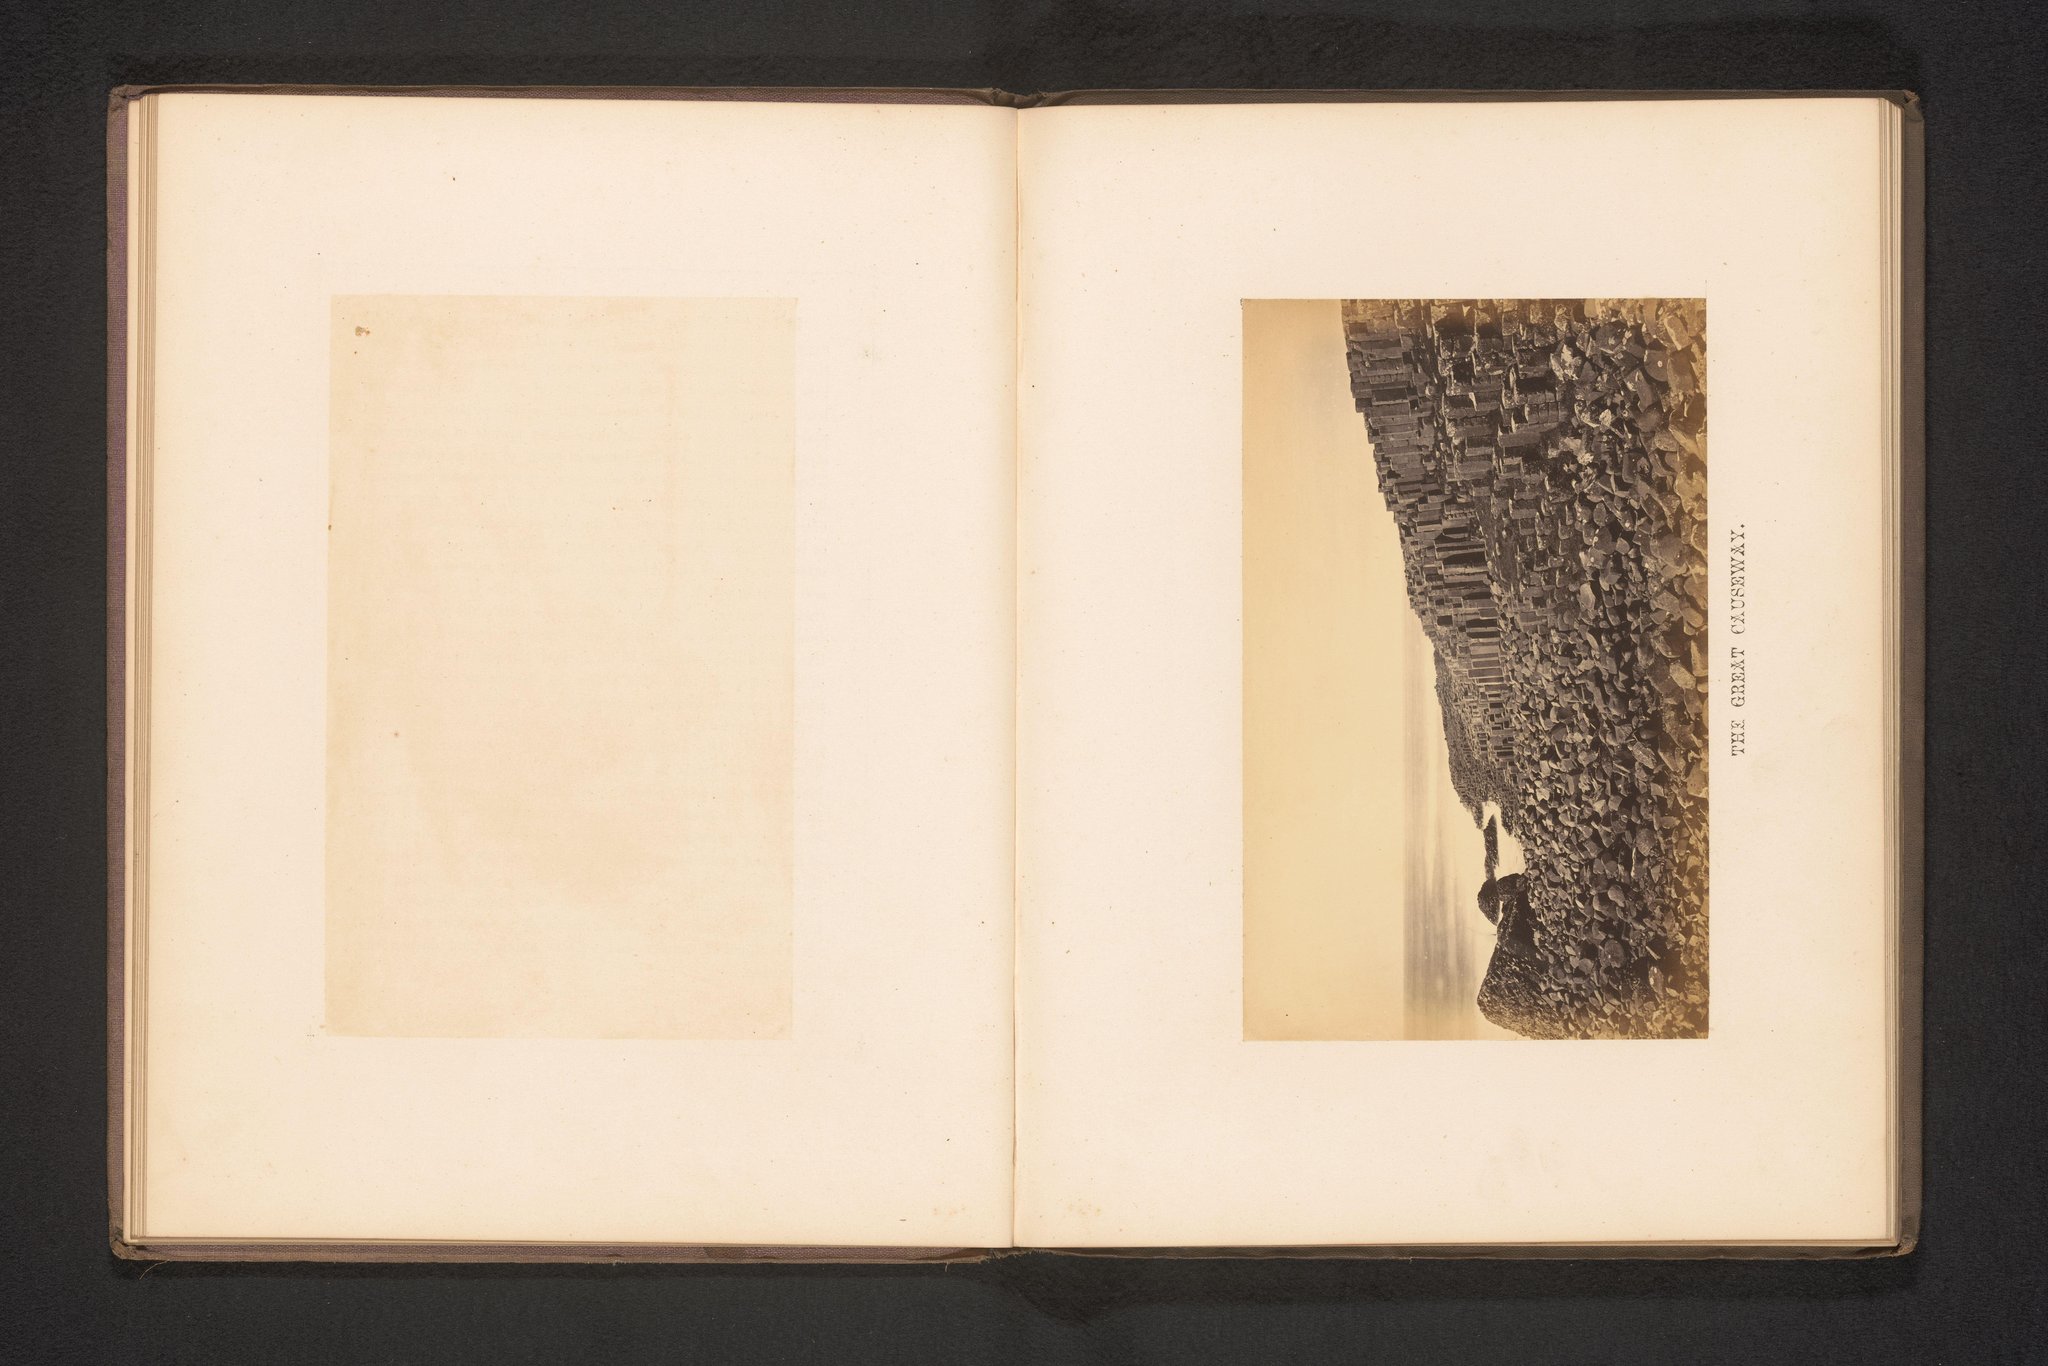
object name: page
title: Gezicht op Causeway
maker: john hudson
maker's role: fotograaf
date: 1862-1867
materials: photographic support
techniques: albumen print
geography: giant's causeway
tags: landscapes with waters, waterscapes, seascapes (in the temperate zone), rock-formations, sea